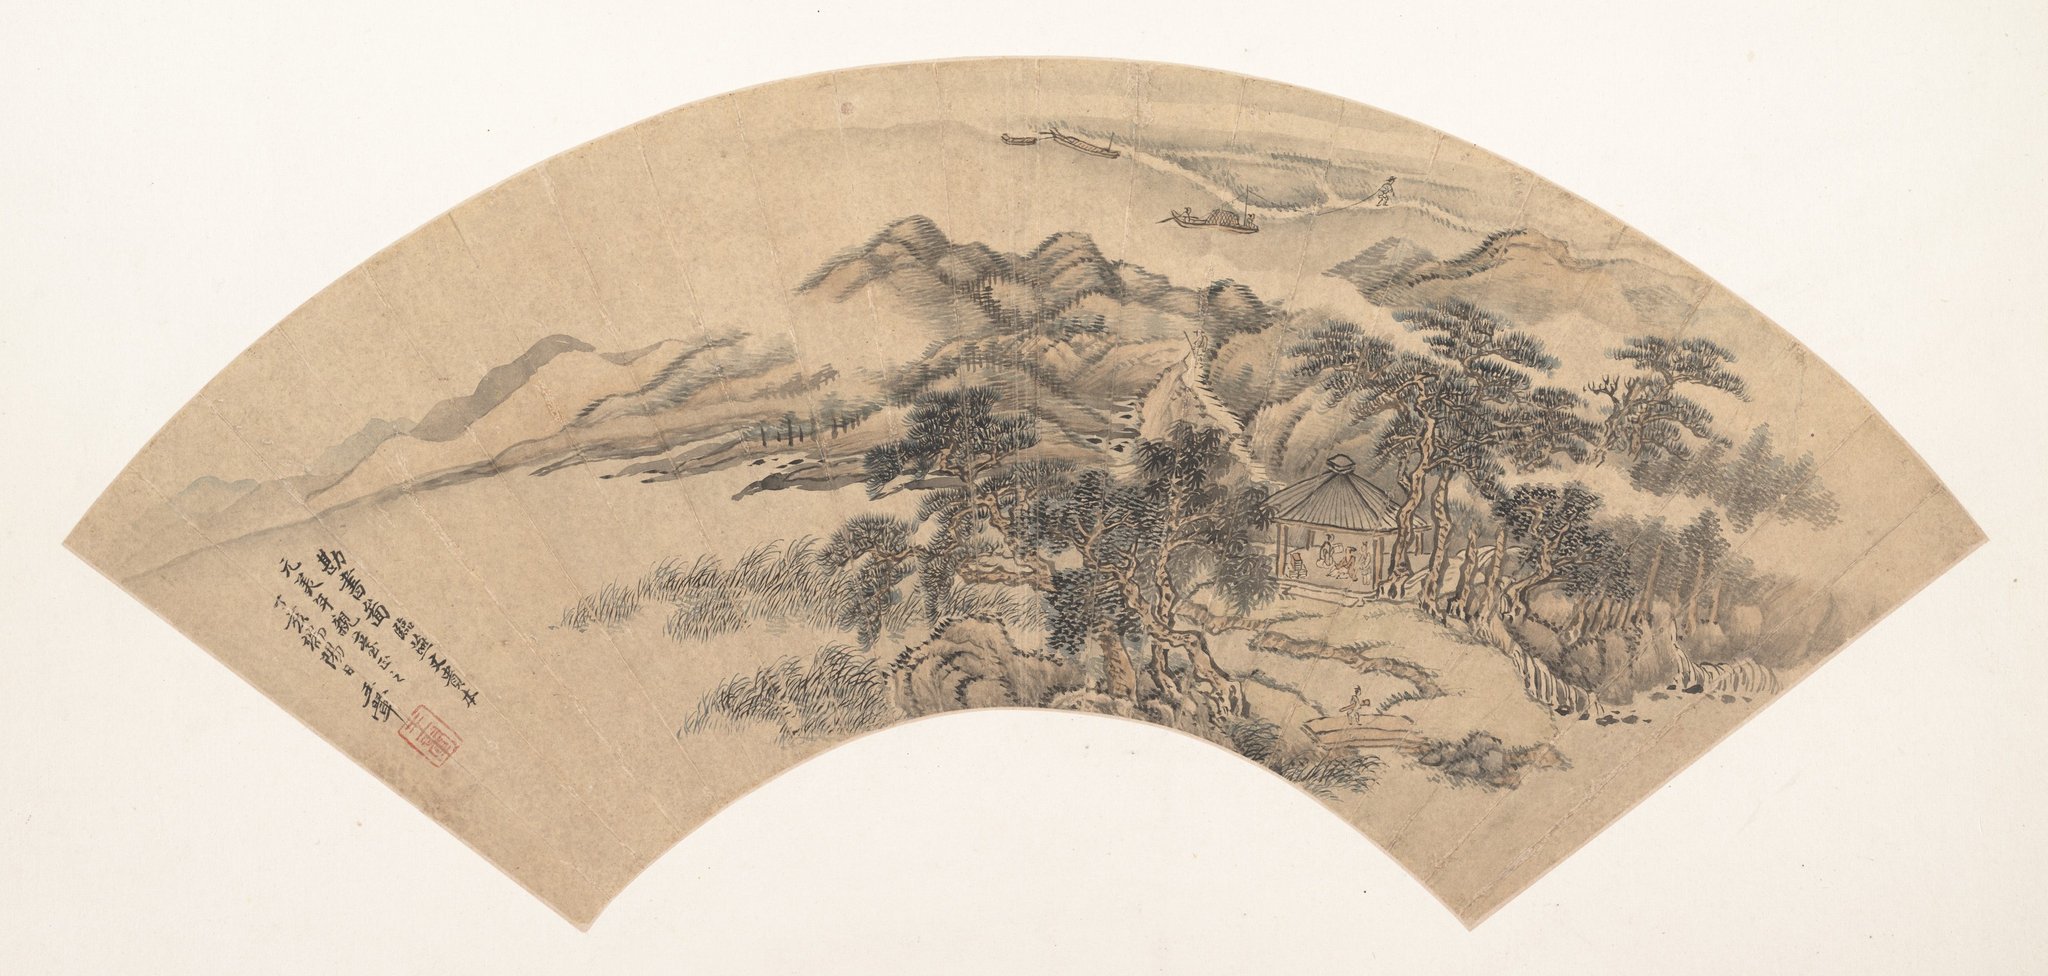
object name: folding fan mounted a an album leaf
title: Landscape in the Style of Yan Wengui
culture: chinese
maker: unidentified artist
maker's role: artist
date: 1701-1800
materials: ink, paper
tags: landscapes